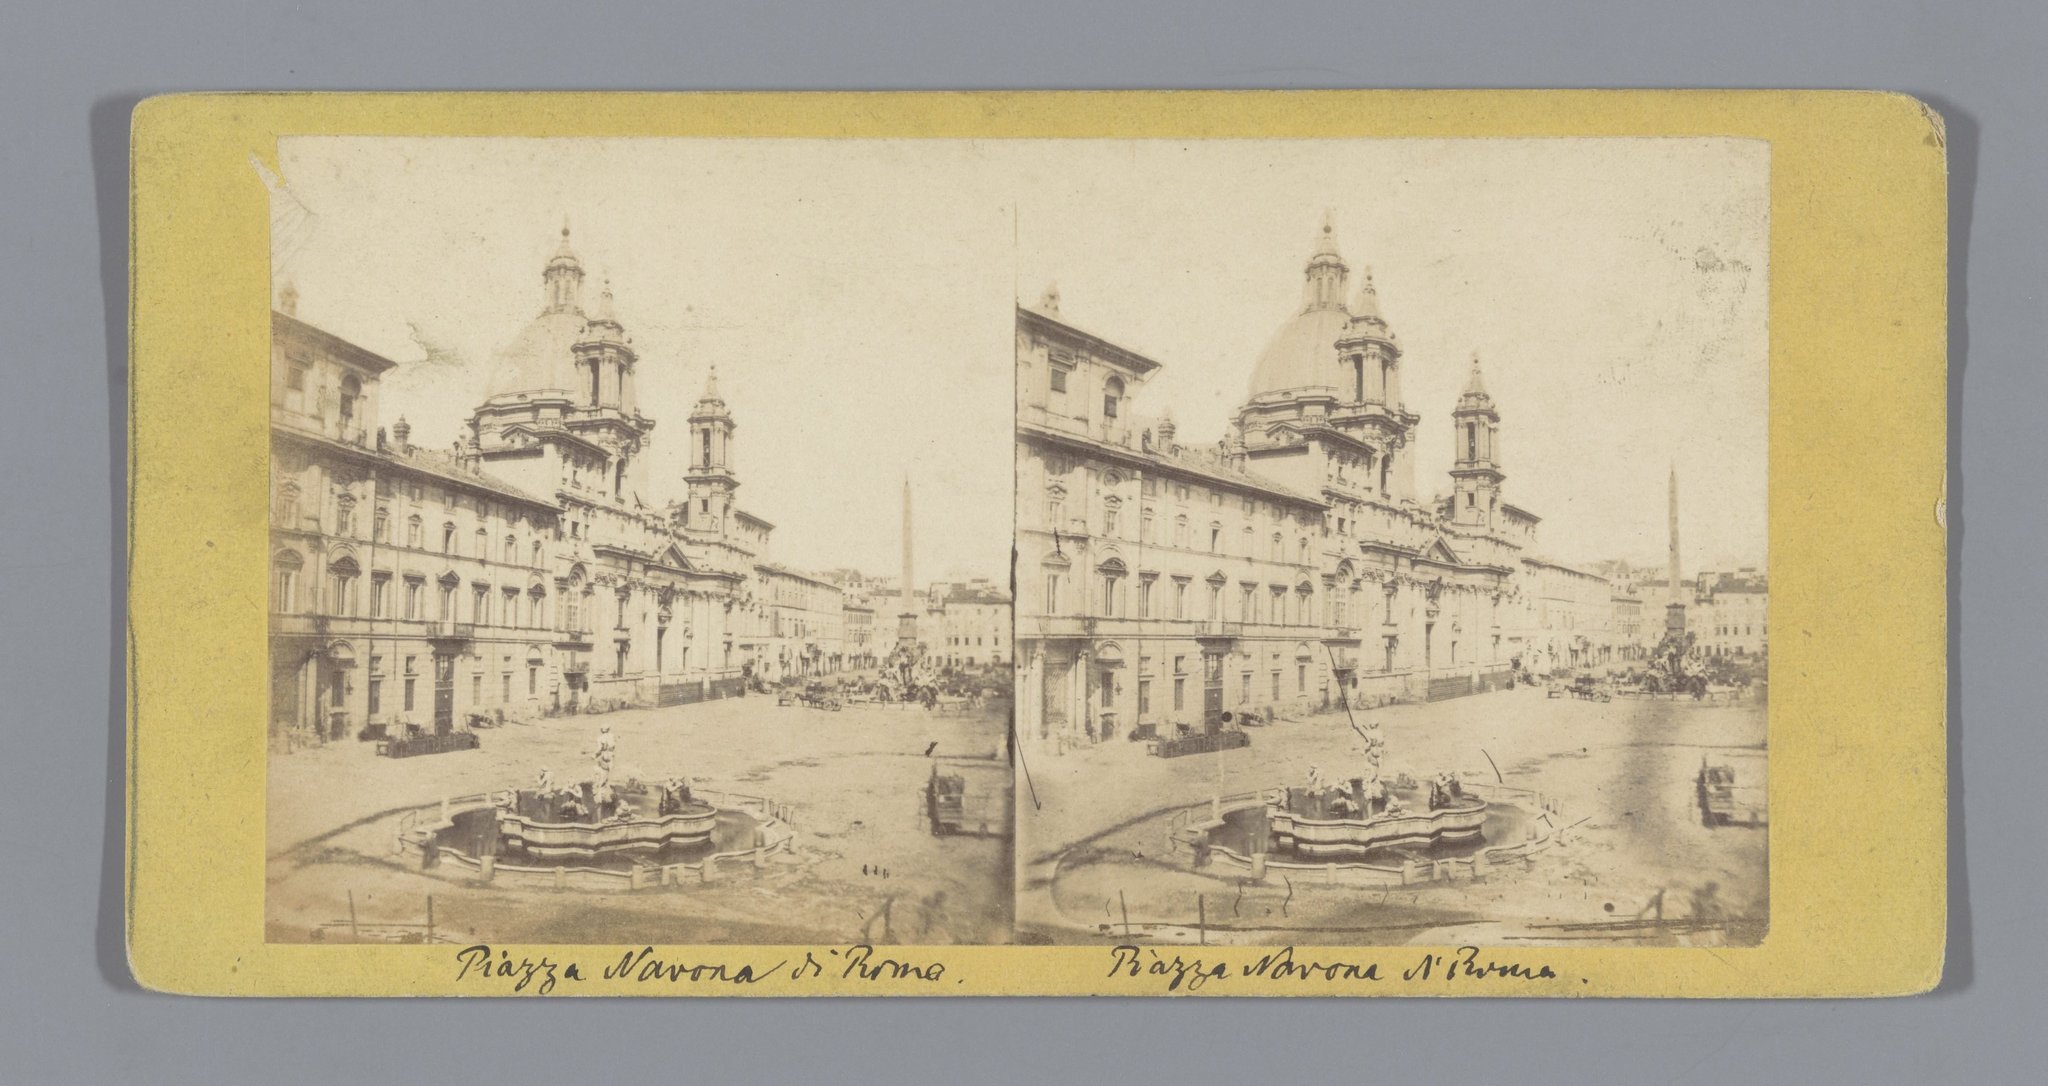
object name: stereograph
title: Gezicht op het Piazza Navona te Rome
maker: Anonymous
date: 1850-1880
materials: cardboard, photographic support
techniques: albumen print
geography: piazza navona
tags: square, place, circus, etc., ornamental fountain, façade (of house or building)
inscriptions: inscription: ‘Piazza Navona di Roma’